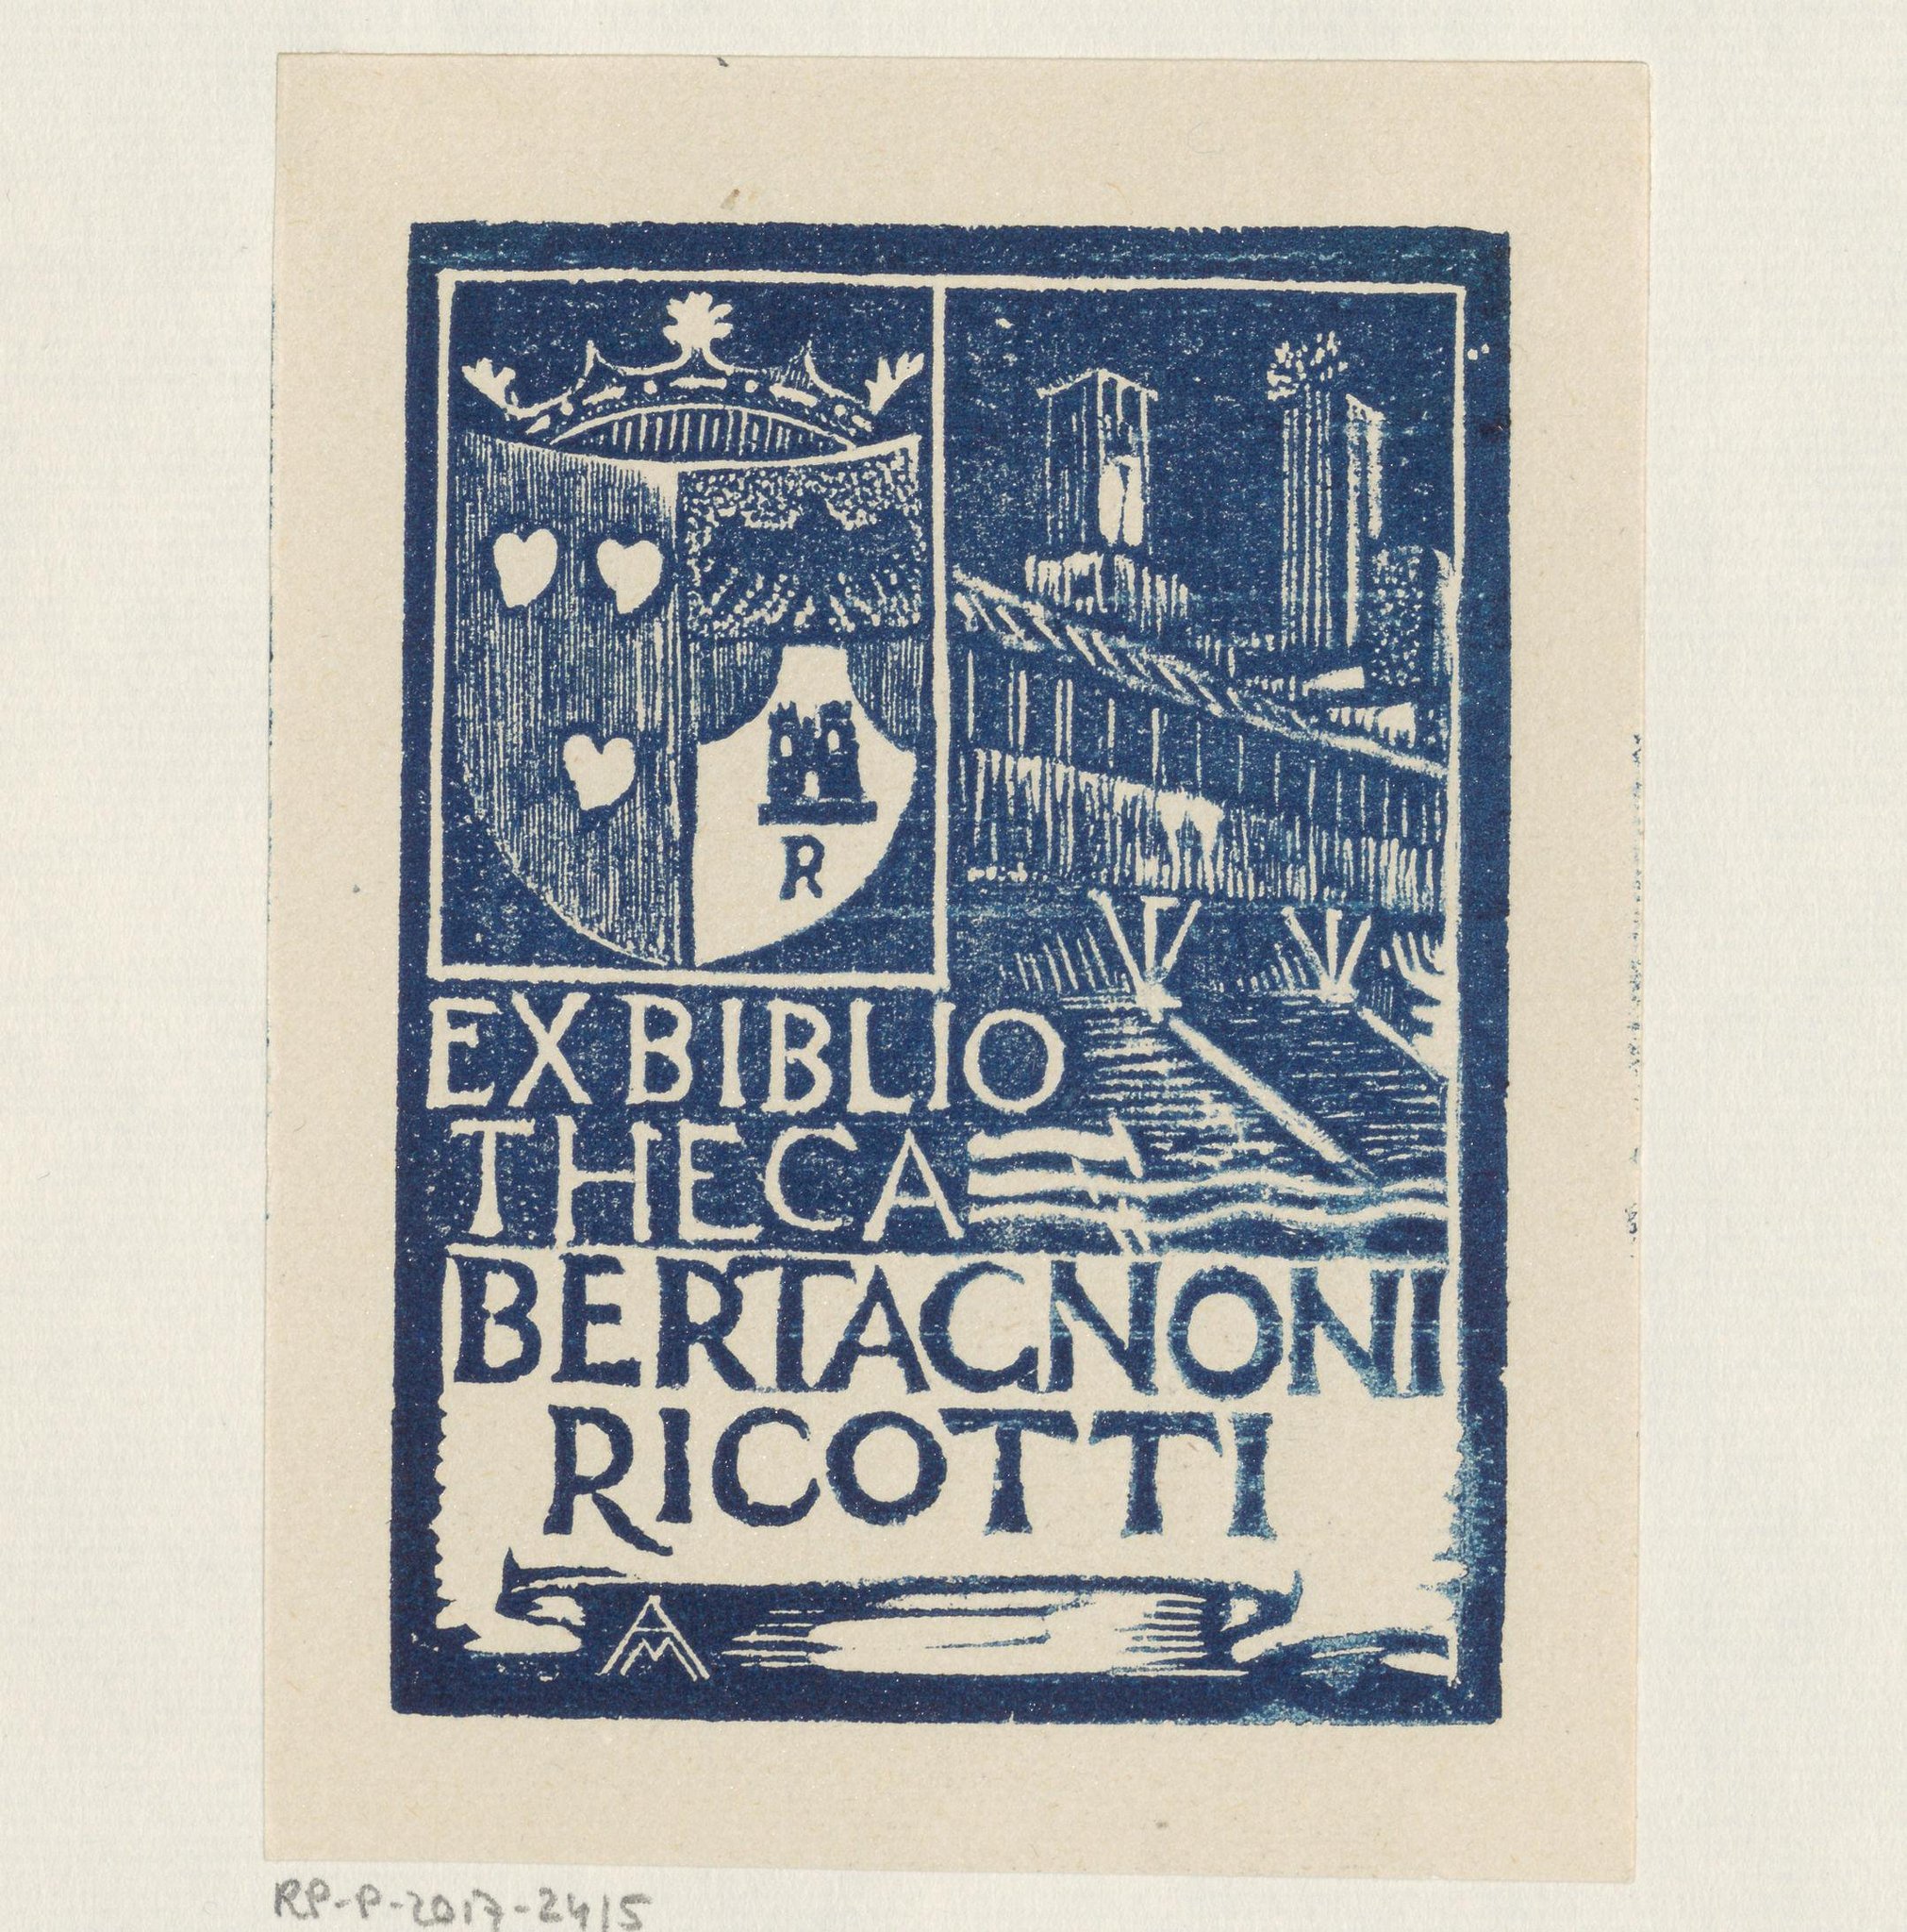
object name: bookplate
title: Ex libris van Bertagnoni Ricotti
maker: Anonymous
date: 1900-1999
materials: paper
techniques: woodcut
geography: italy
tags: castle, armorial bearing, heraldry